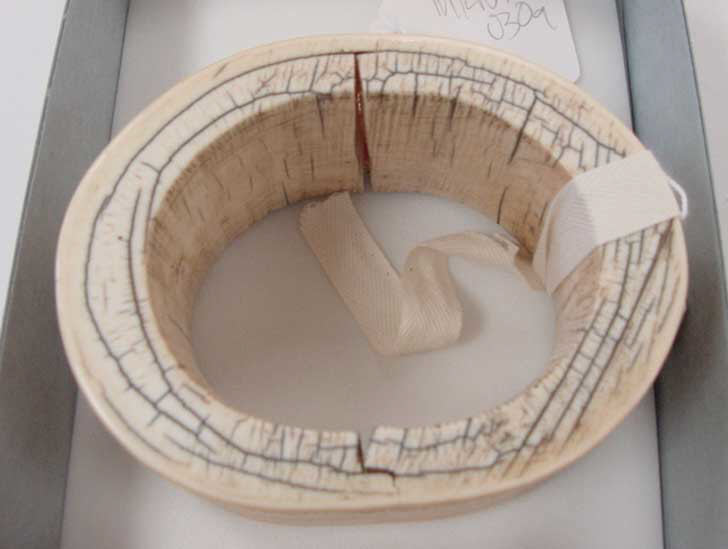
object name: jewelry set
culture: naga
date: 1801-1900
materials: ivory